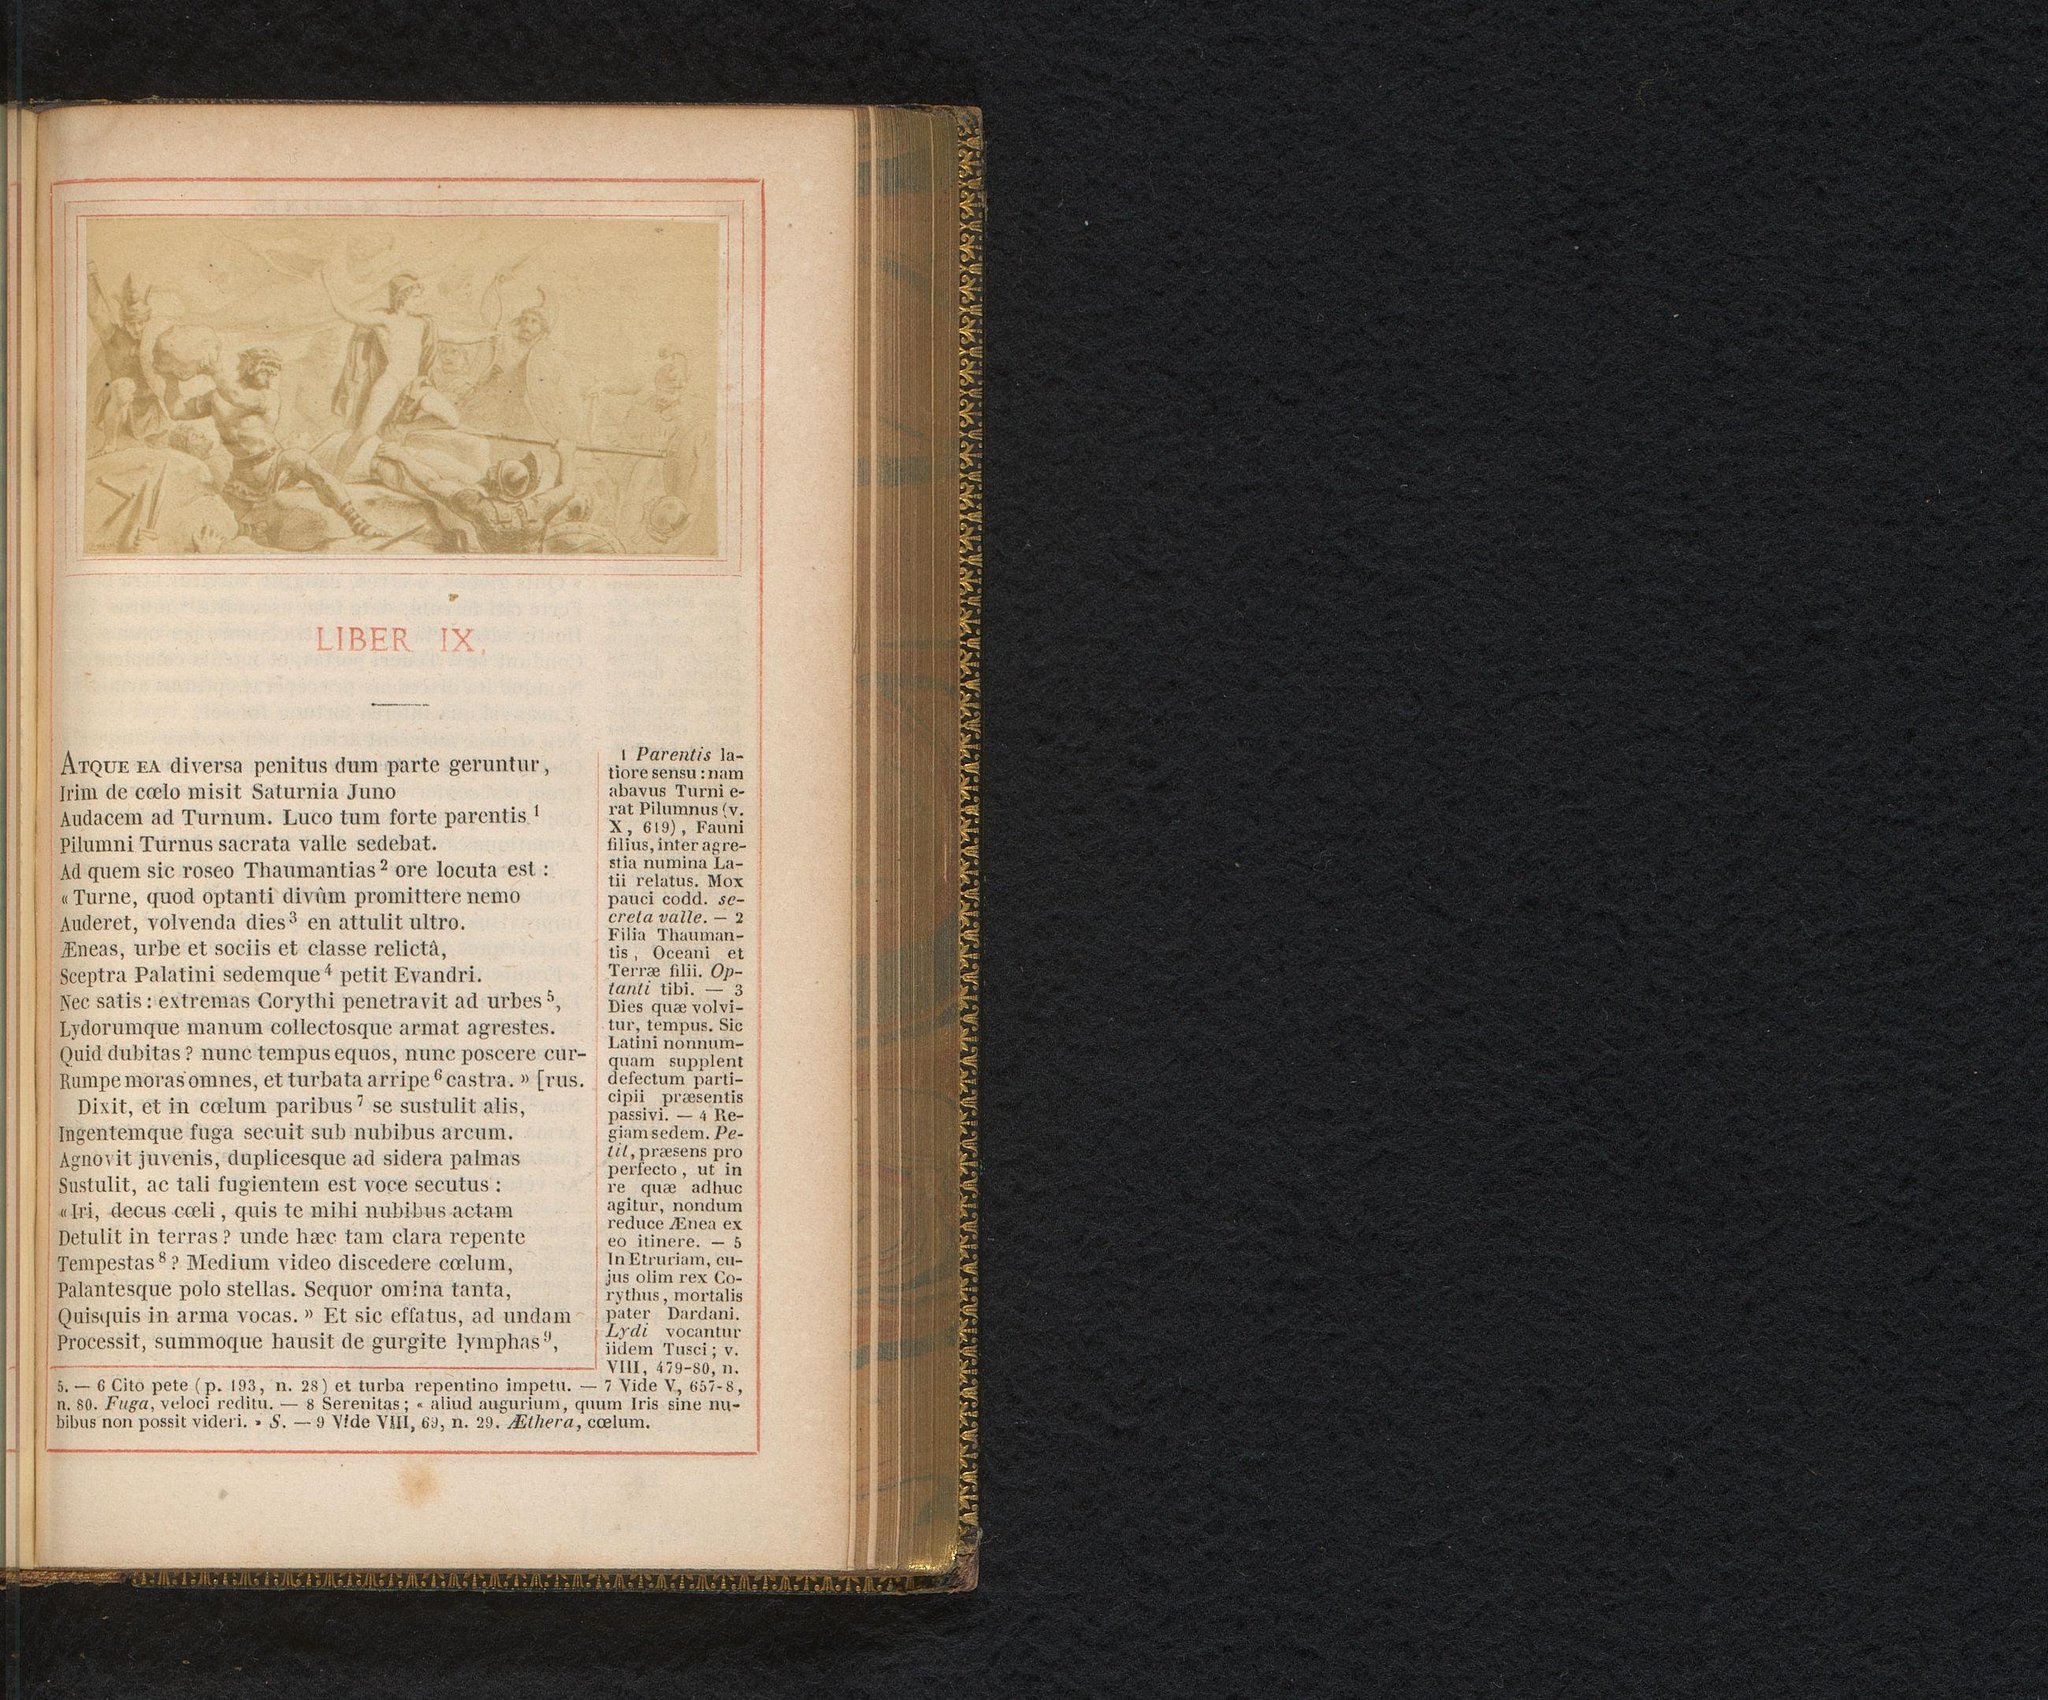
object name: reproduction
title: Fotoreproductie van een schilderij van Aeneas tijdens de Slag bij Latium, scène uit Virgilius' Aeneis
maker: Anonymous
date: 1853-1858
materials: paper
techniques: albumen print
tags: the return of aeneas and the relief ~ battle of latinum (virgil, aeneid x)